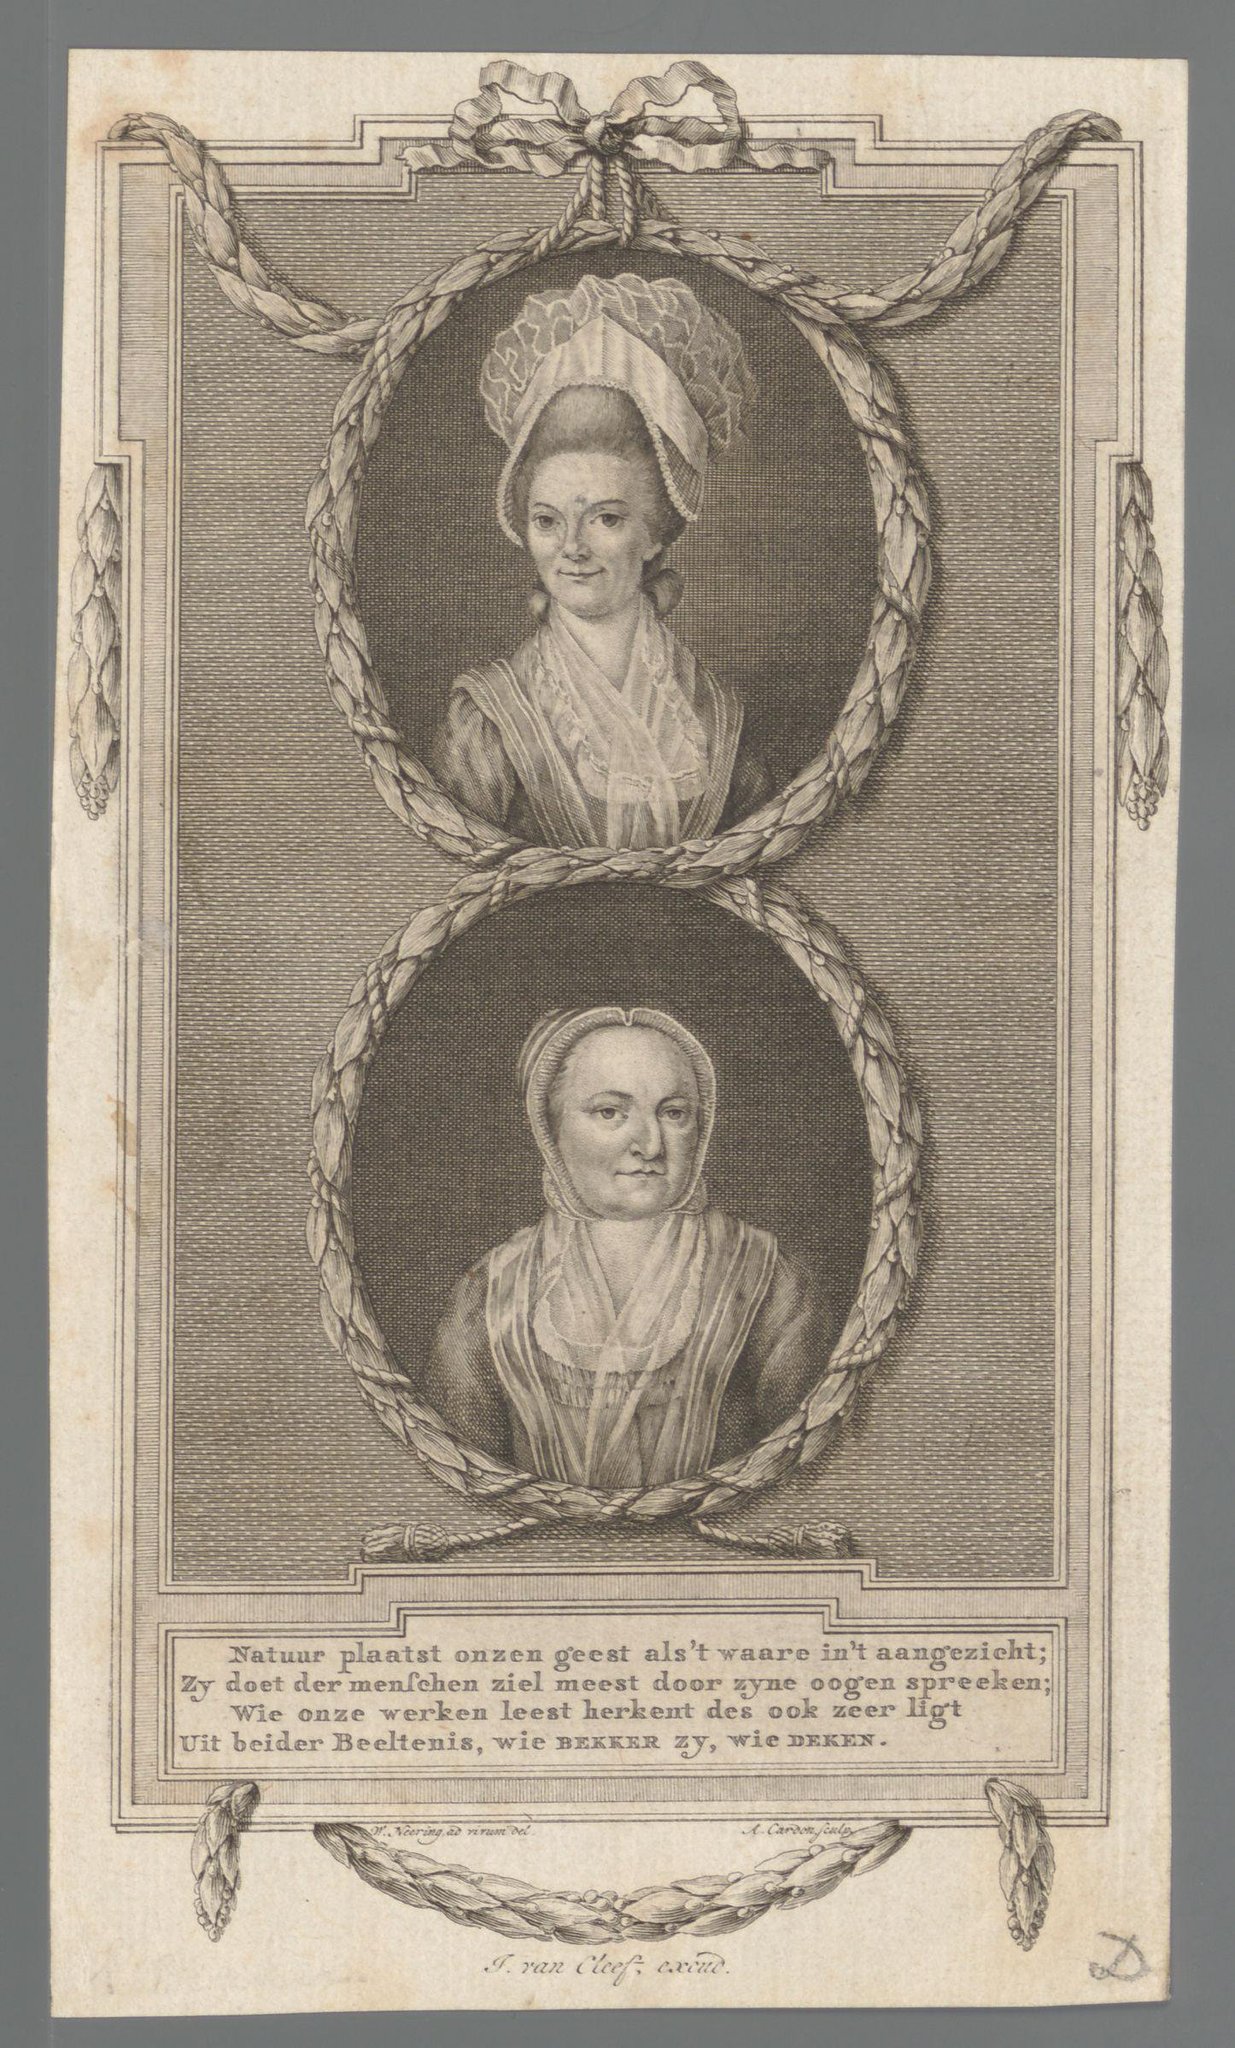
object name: print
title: Portretten van Betje Wolff en Agatha Deken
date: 1778-1800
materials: paper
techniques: engraving, etching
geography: the hague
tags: flushing, elisabeth bekker, the hague, agatha deken, adult woman, historical persons, writer, poet, author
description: Bij deze portretten een begeleidend blad met verzen getiteld: Een viertal verzen, op den alom befaamden ex-regent R.M. van Goens. Schelm voor't vaderland, en beminnaar van het Oranje huis / Een vyftal verzen, op den berugten Petrus Hofstede, schelm voor't vaderland, en beminnaar van het Oranje huis. S.l.s.n. [1782]. De portretten zijn door Muller beschreven bij het jaar 1784.